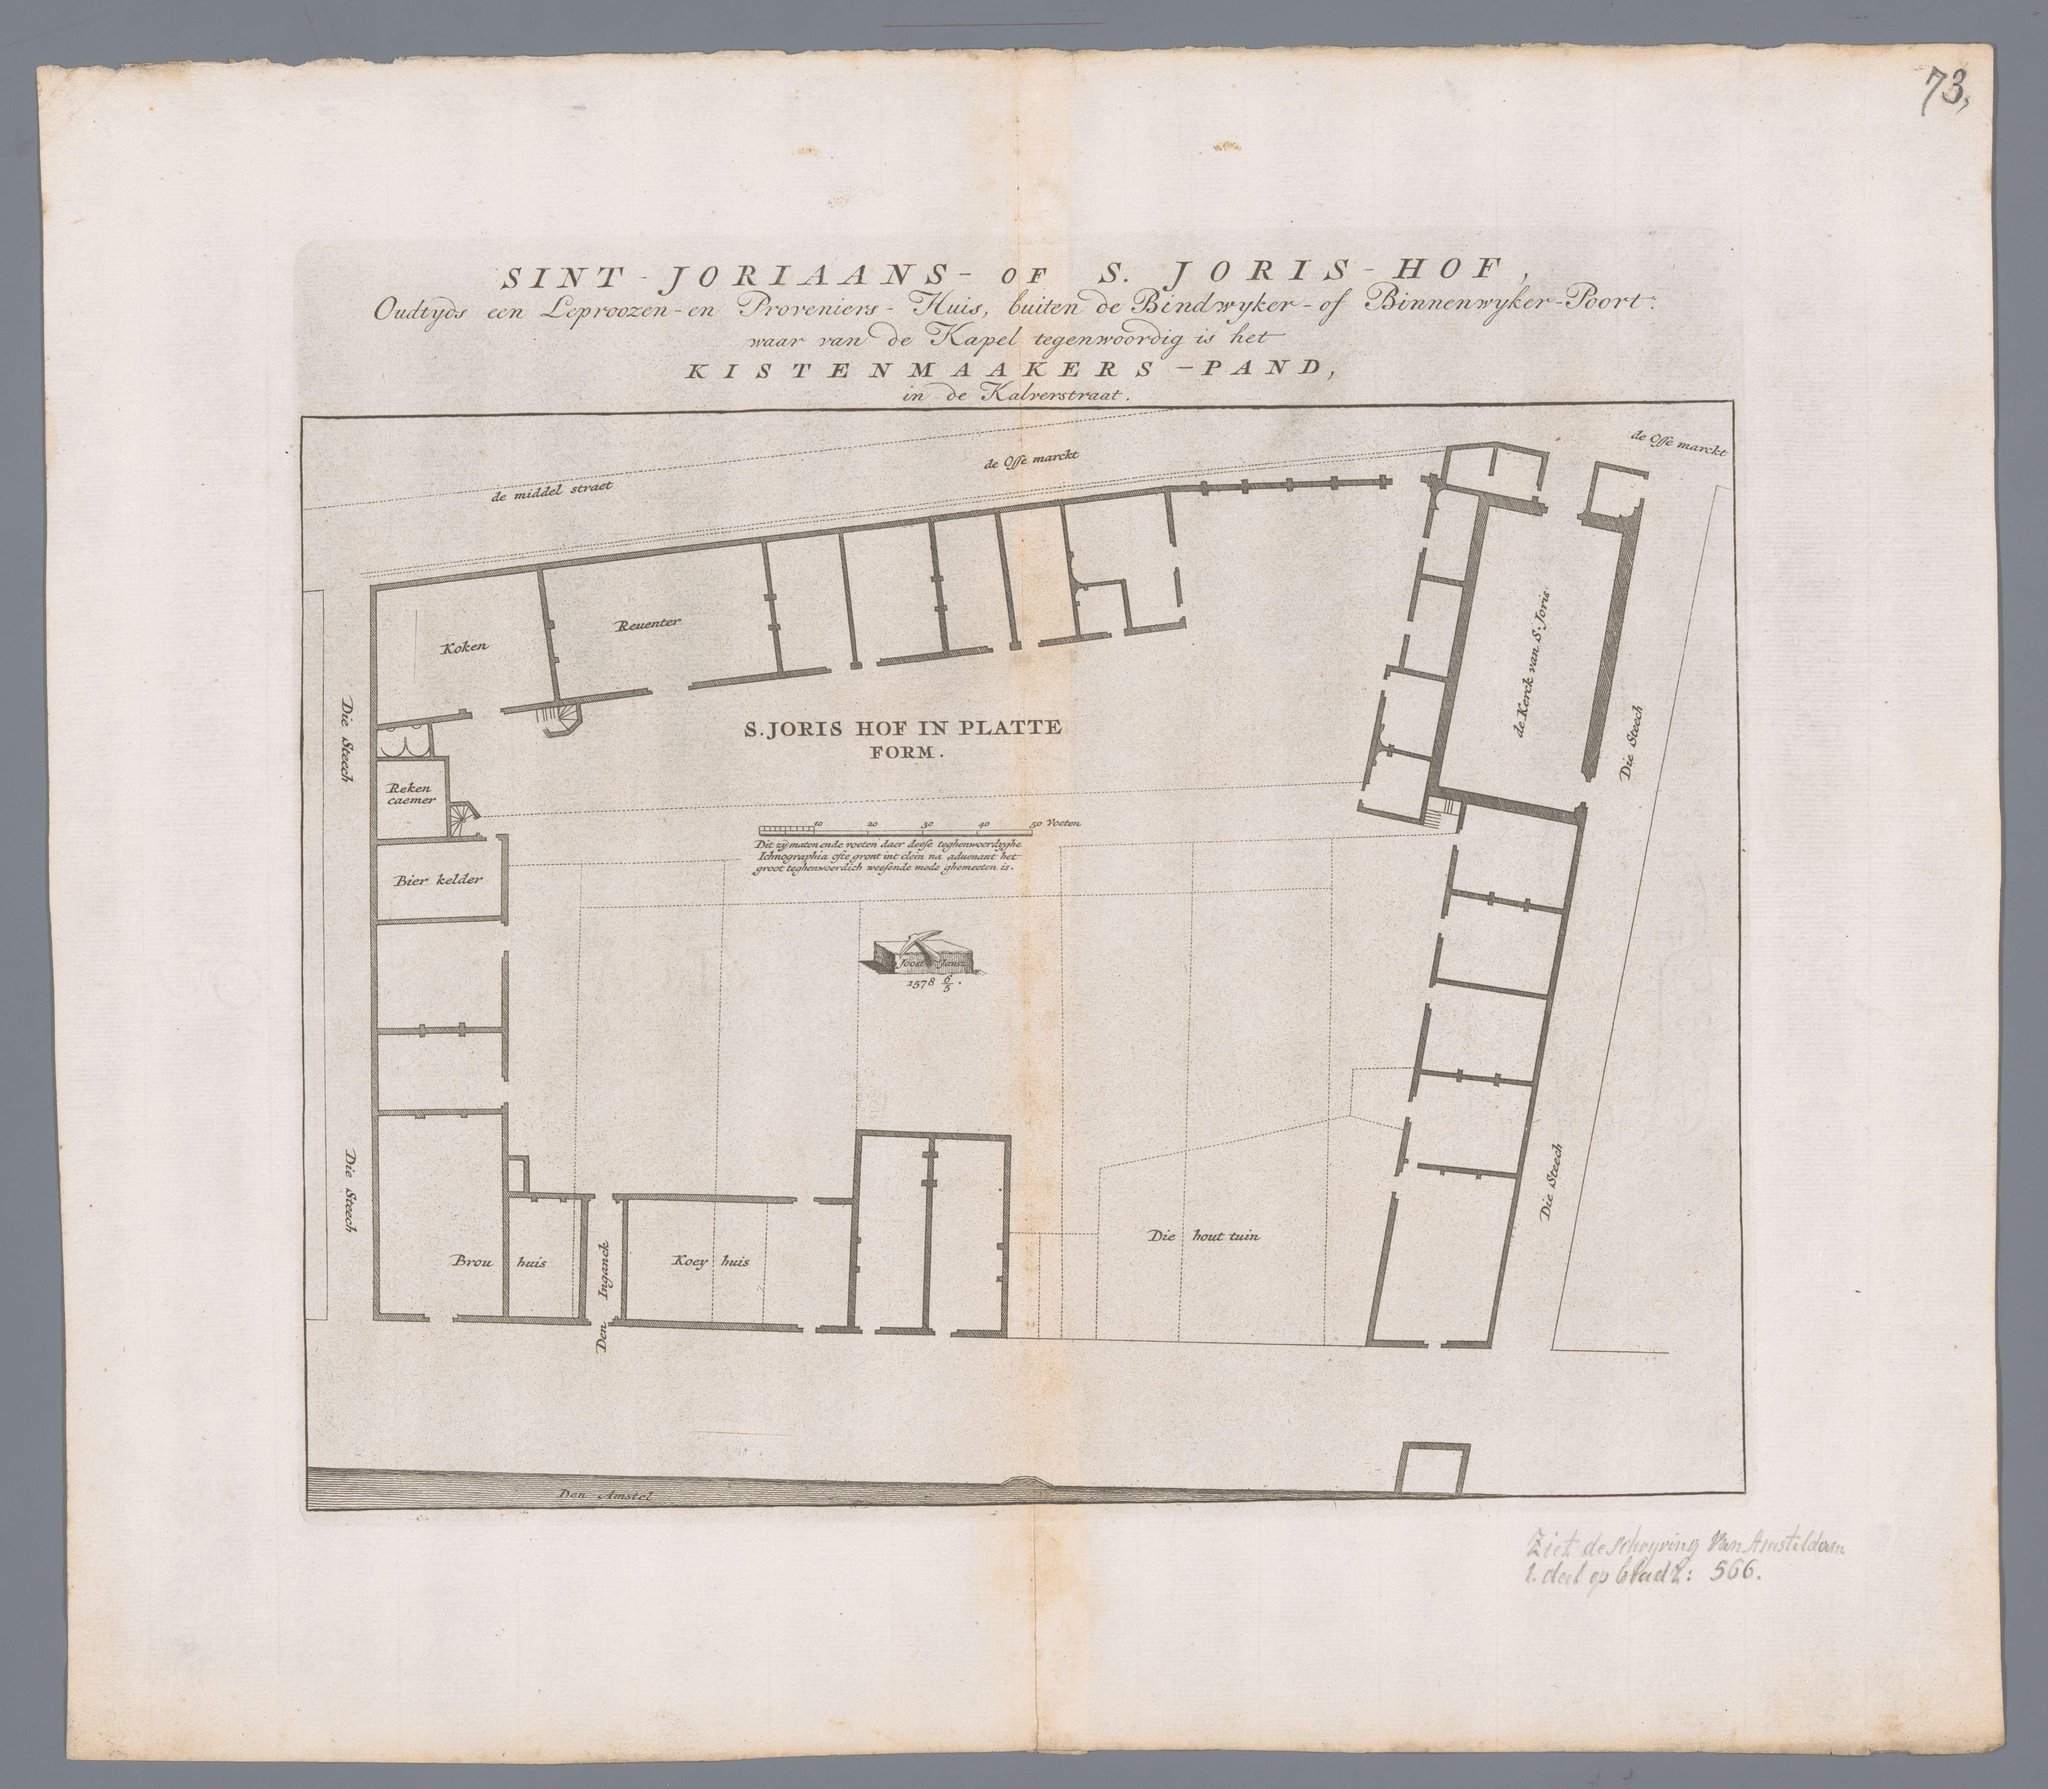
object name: area plan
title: Plattegrond van het Sint-Jorishof te Amsterdam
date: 1765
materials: paper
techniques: etching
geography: amsterdam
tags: alms-house (dutch: 'hofje'), plan, map of garden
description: Prent uit: Wagenaar, Jan. Amsterdam, in zyne opkomst, aanwas, geschiedenissen (…). Amsterdam: Isaak Tirion, 1765, dl. 2, tussen p. 316 en 317.